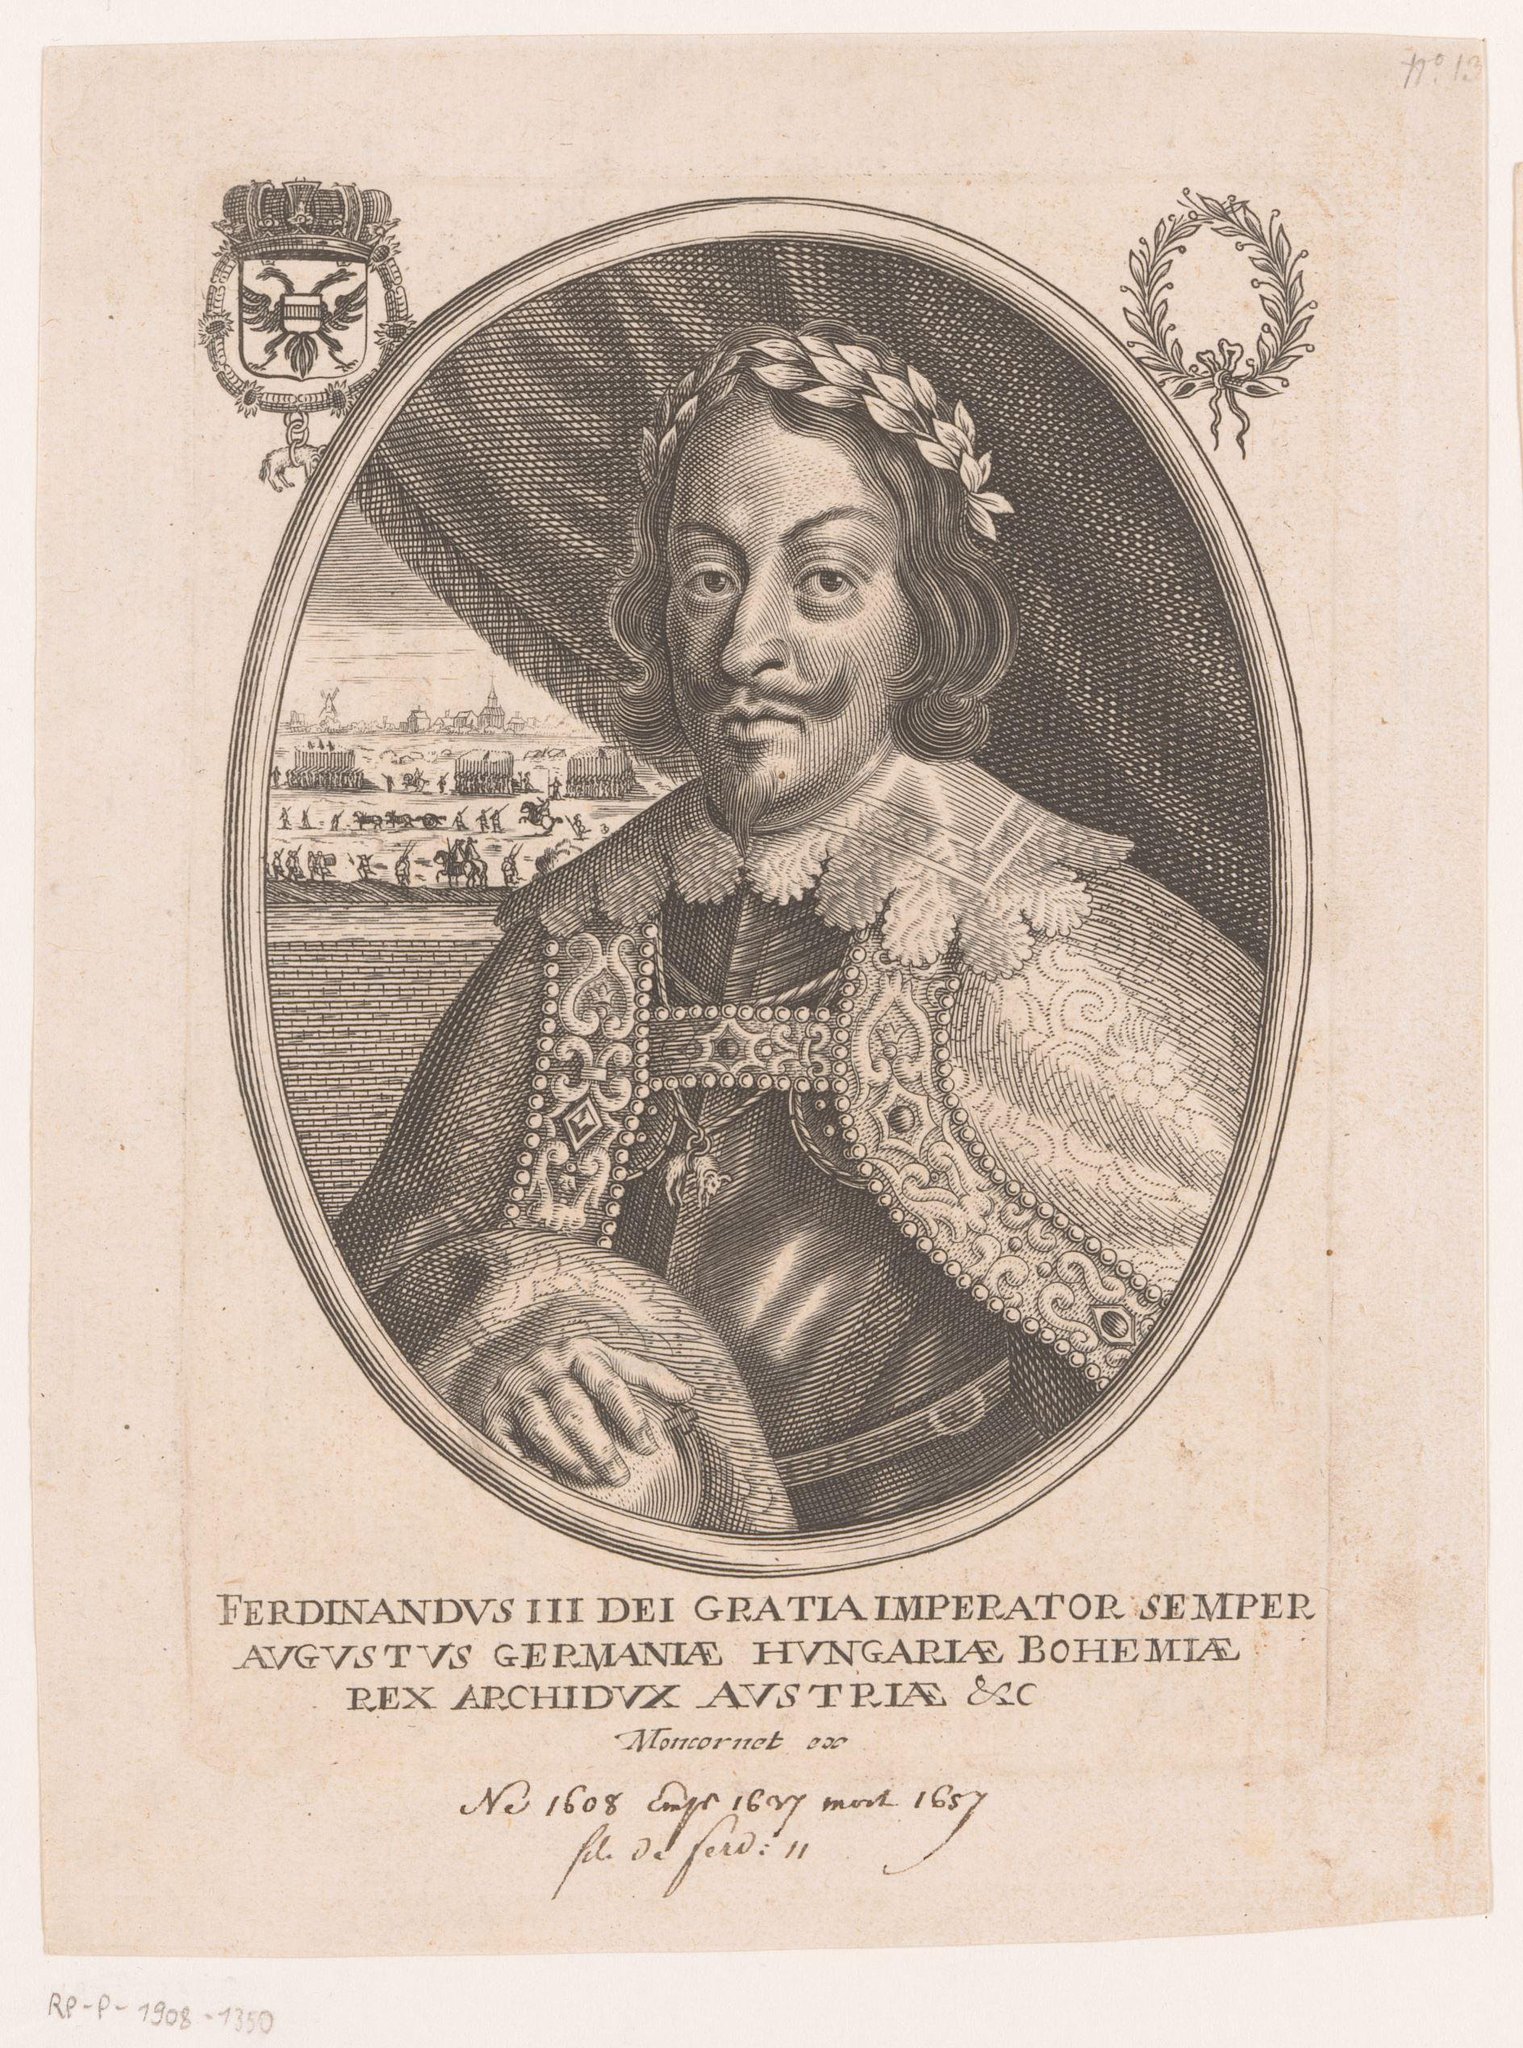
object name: print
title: Portret van keizer Ferdinand III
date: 1637-1668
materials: paper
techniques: engraving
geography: france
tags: vienna, ferdinand iii (duits keizer), historical persons, emperor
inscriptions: collector's mark: Lugt 2228